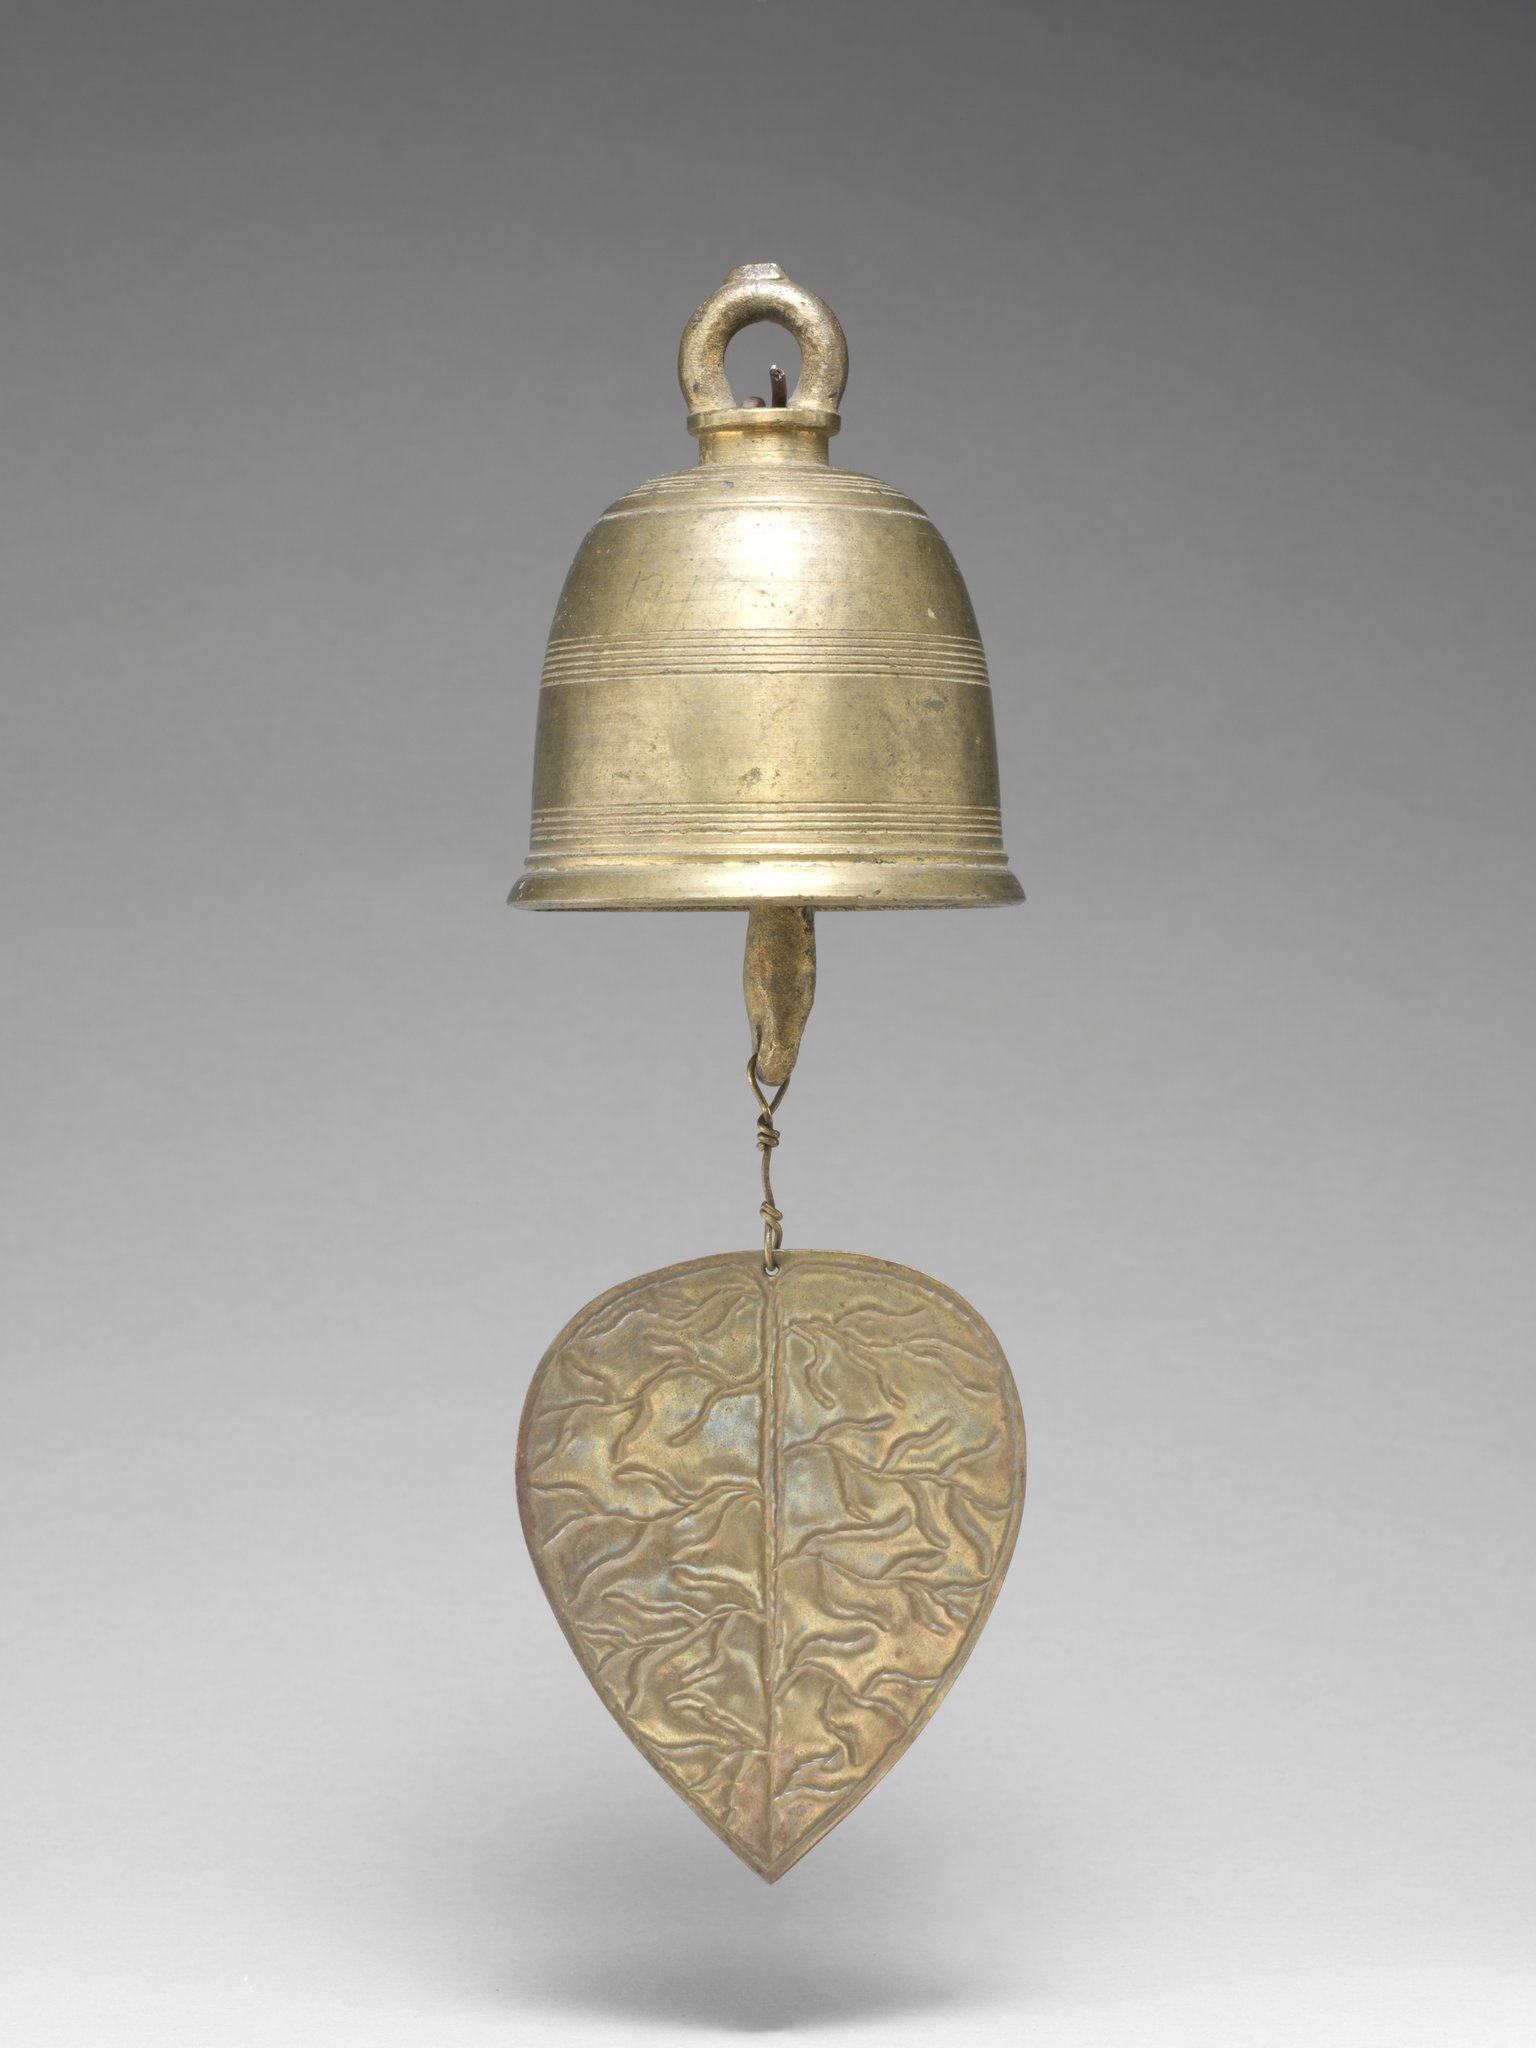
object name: khew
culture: burmese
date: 1867-1900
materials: metal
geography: myanmar